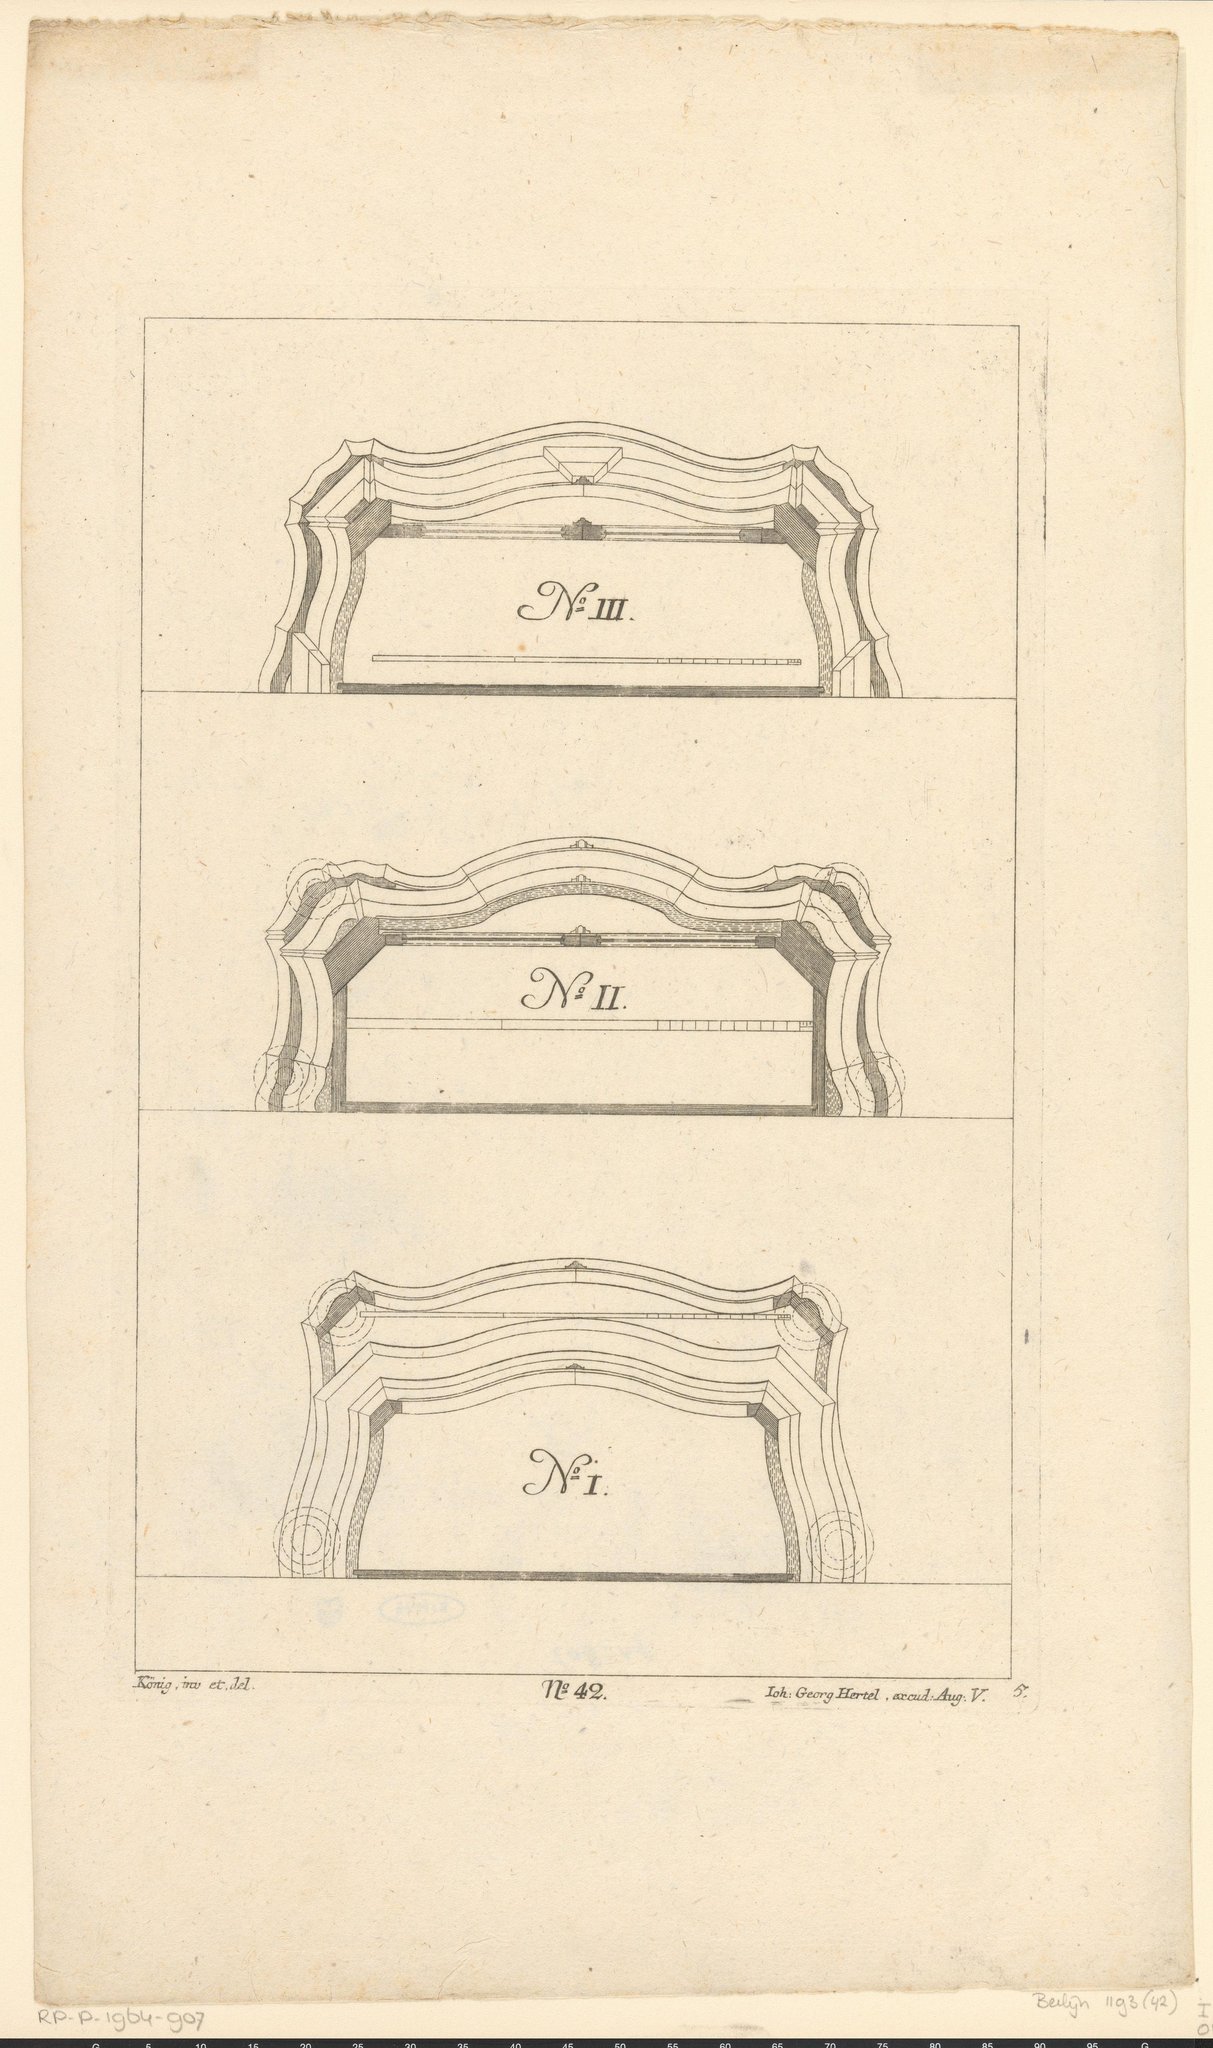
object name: ornament print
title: Bovenaanzichten van drie kasten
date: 1705-1775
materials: paper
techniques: engraving, etching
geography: augsburg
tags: ornamental cupboard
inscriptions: collector's mark: Lugt 2228, collector's mark: Lugt 2760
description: Ontwerpen van bovenaanzichten van drie kasten. Uitgeversnummer 42.